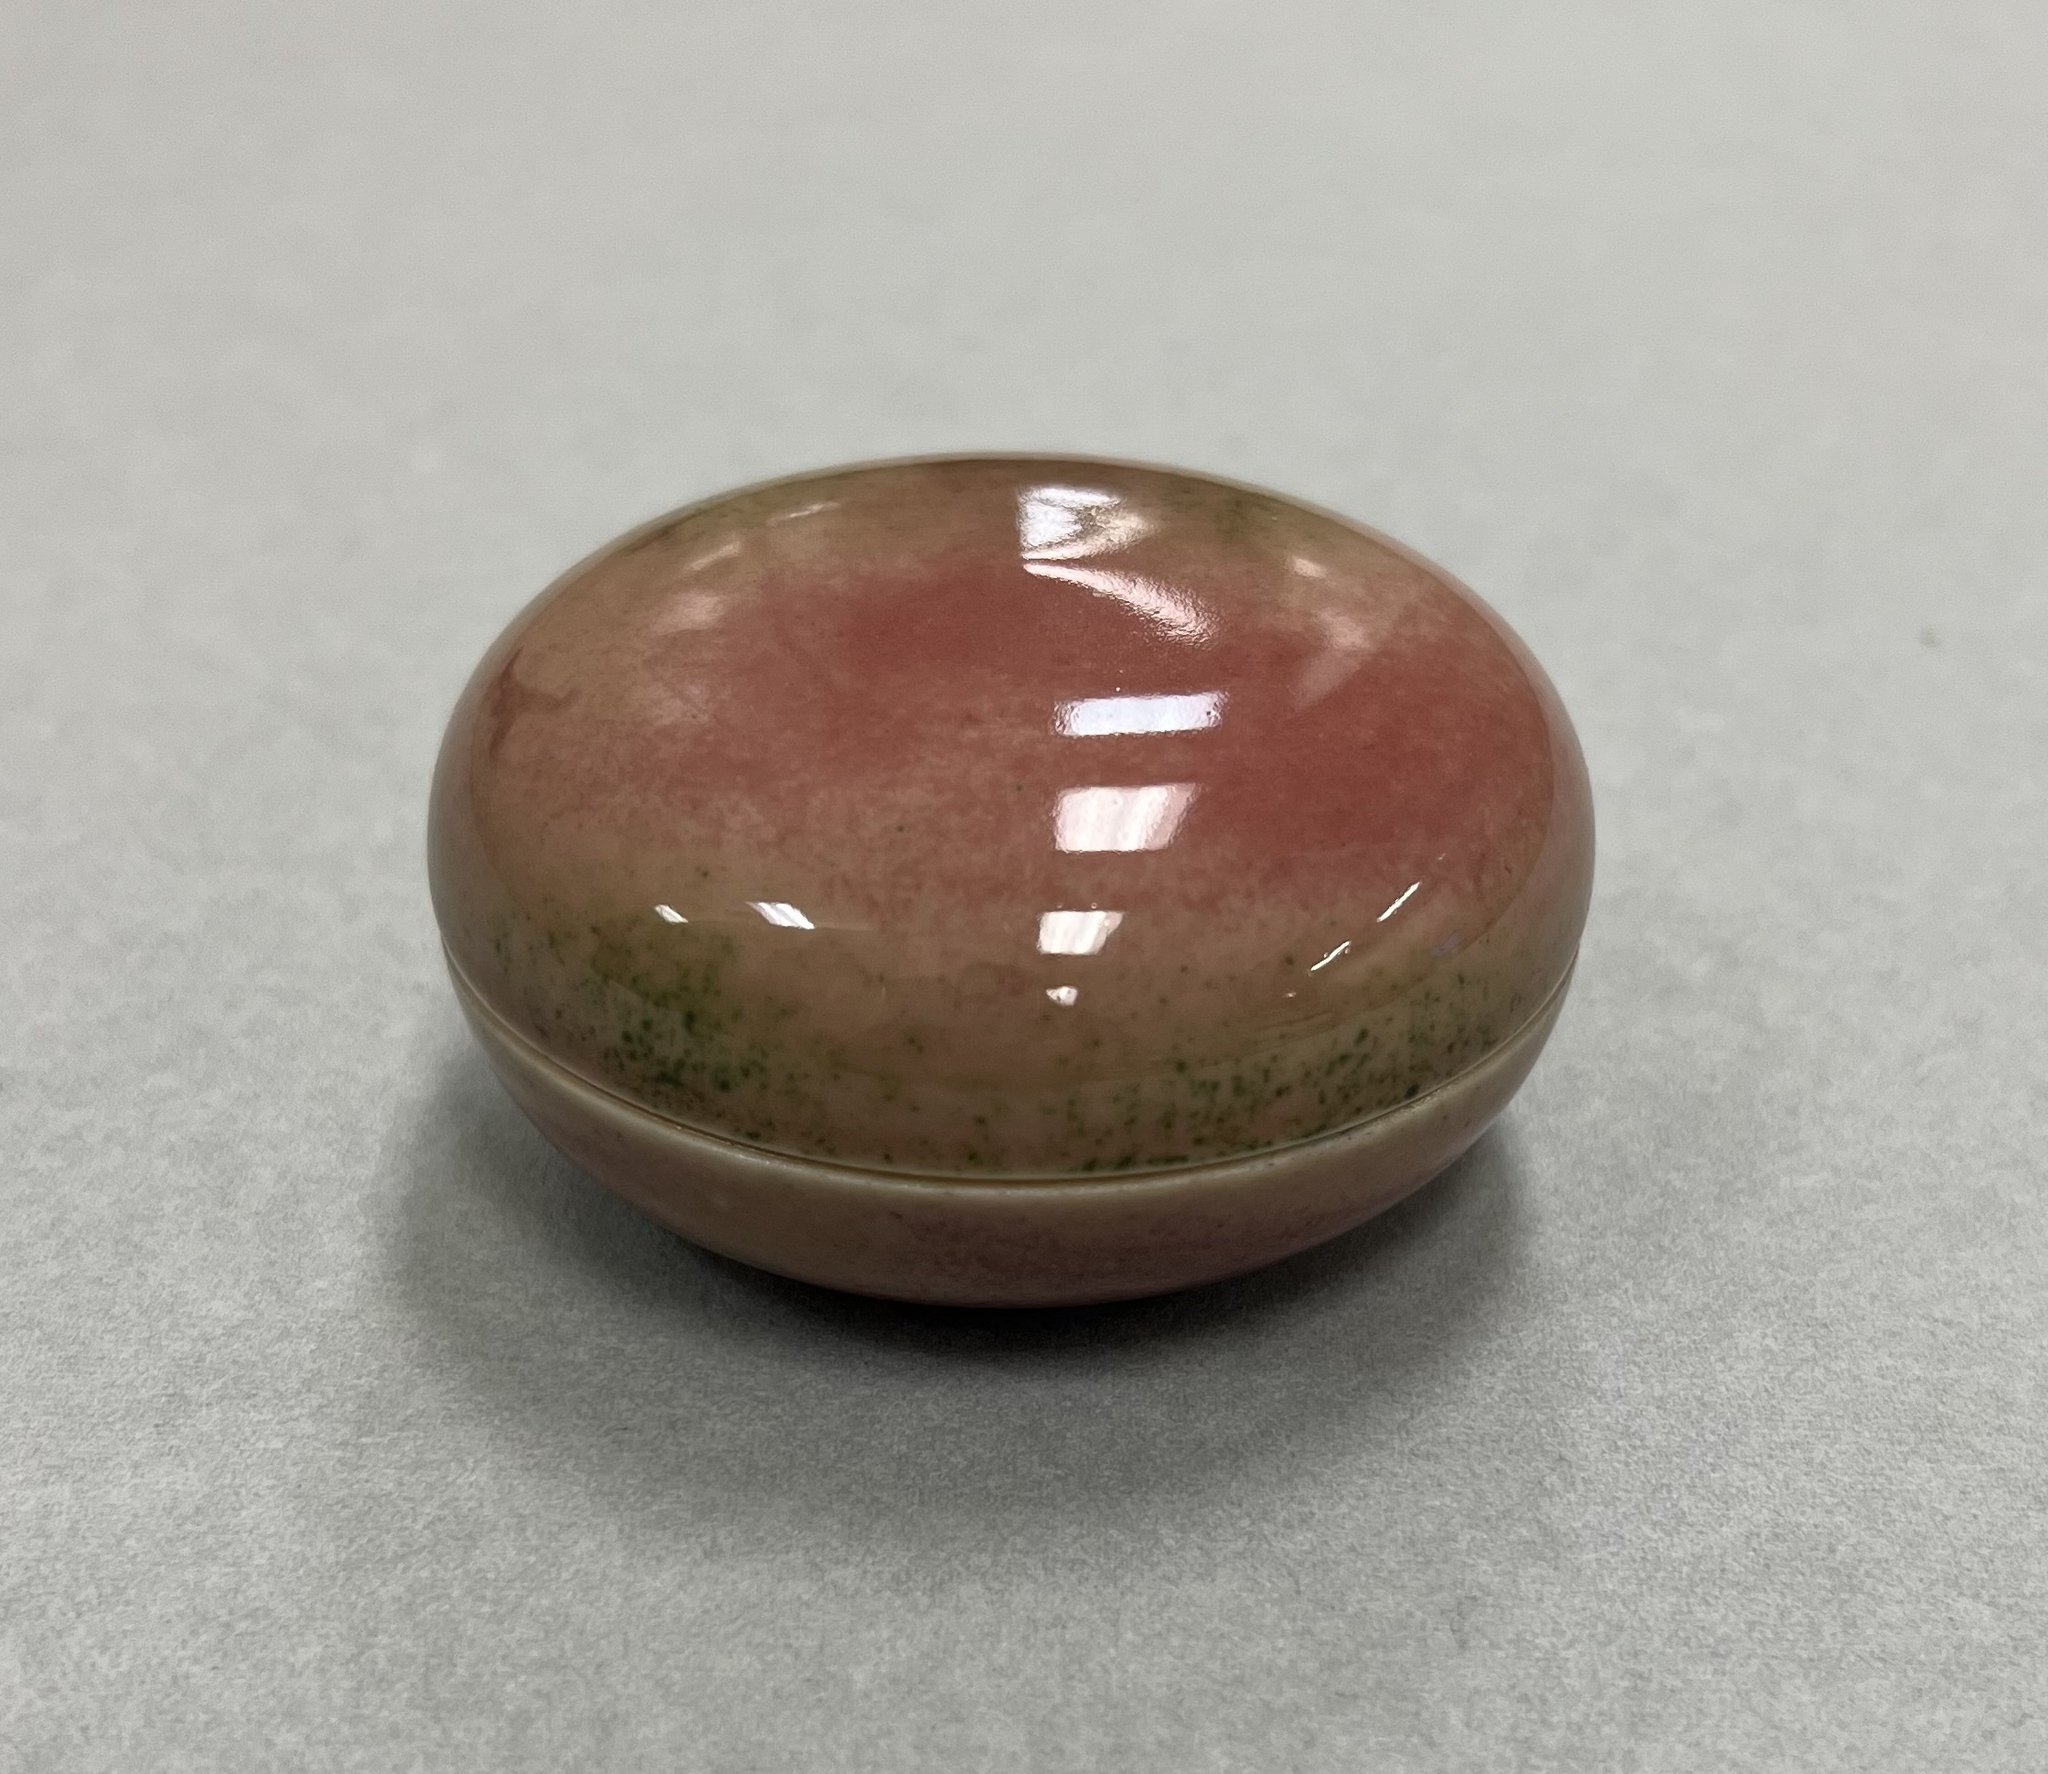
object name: covered box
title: Seal-Paste Box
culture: chinese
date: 1662-1722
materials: glaze, porcelain